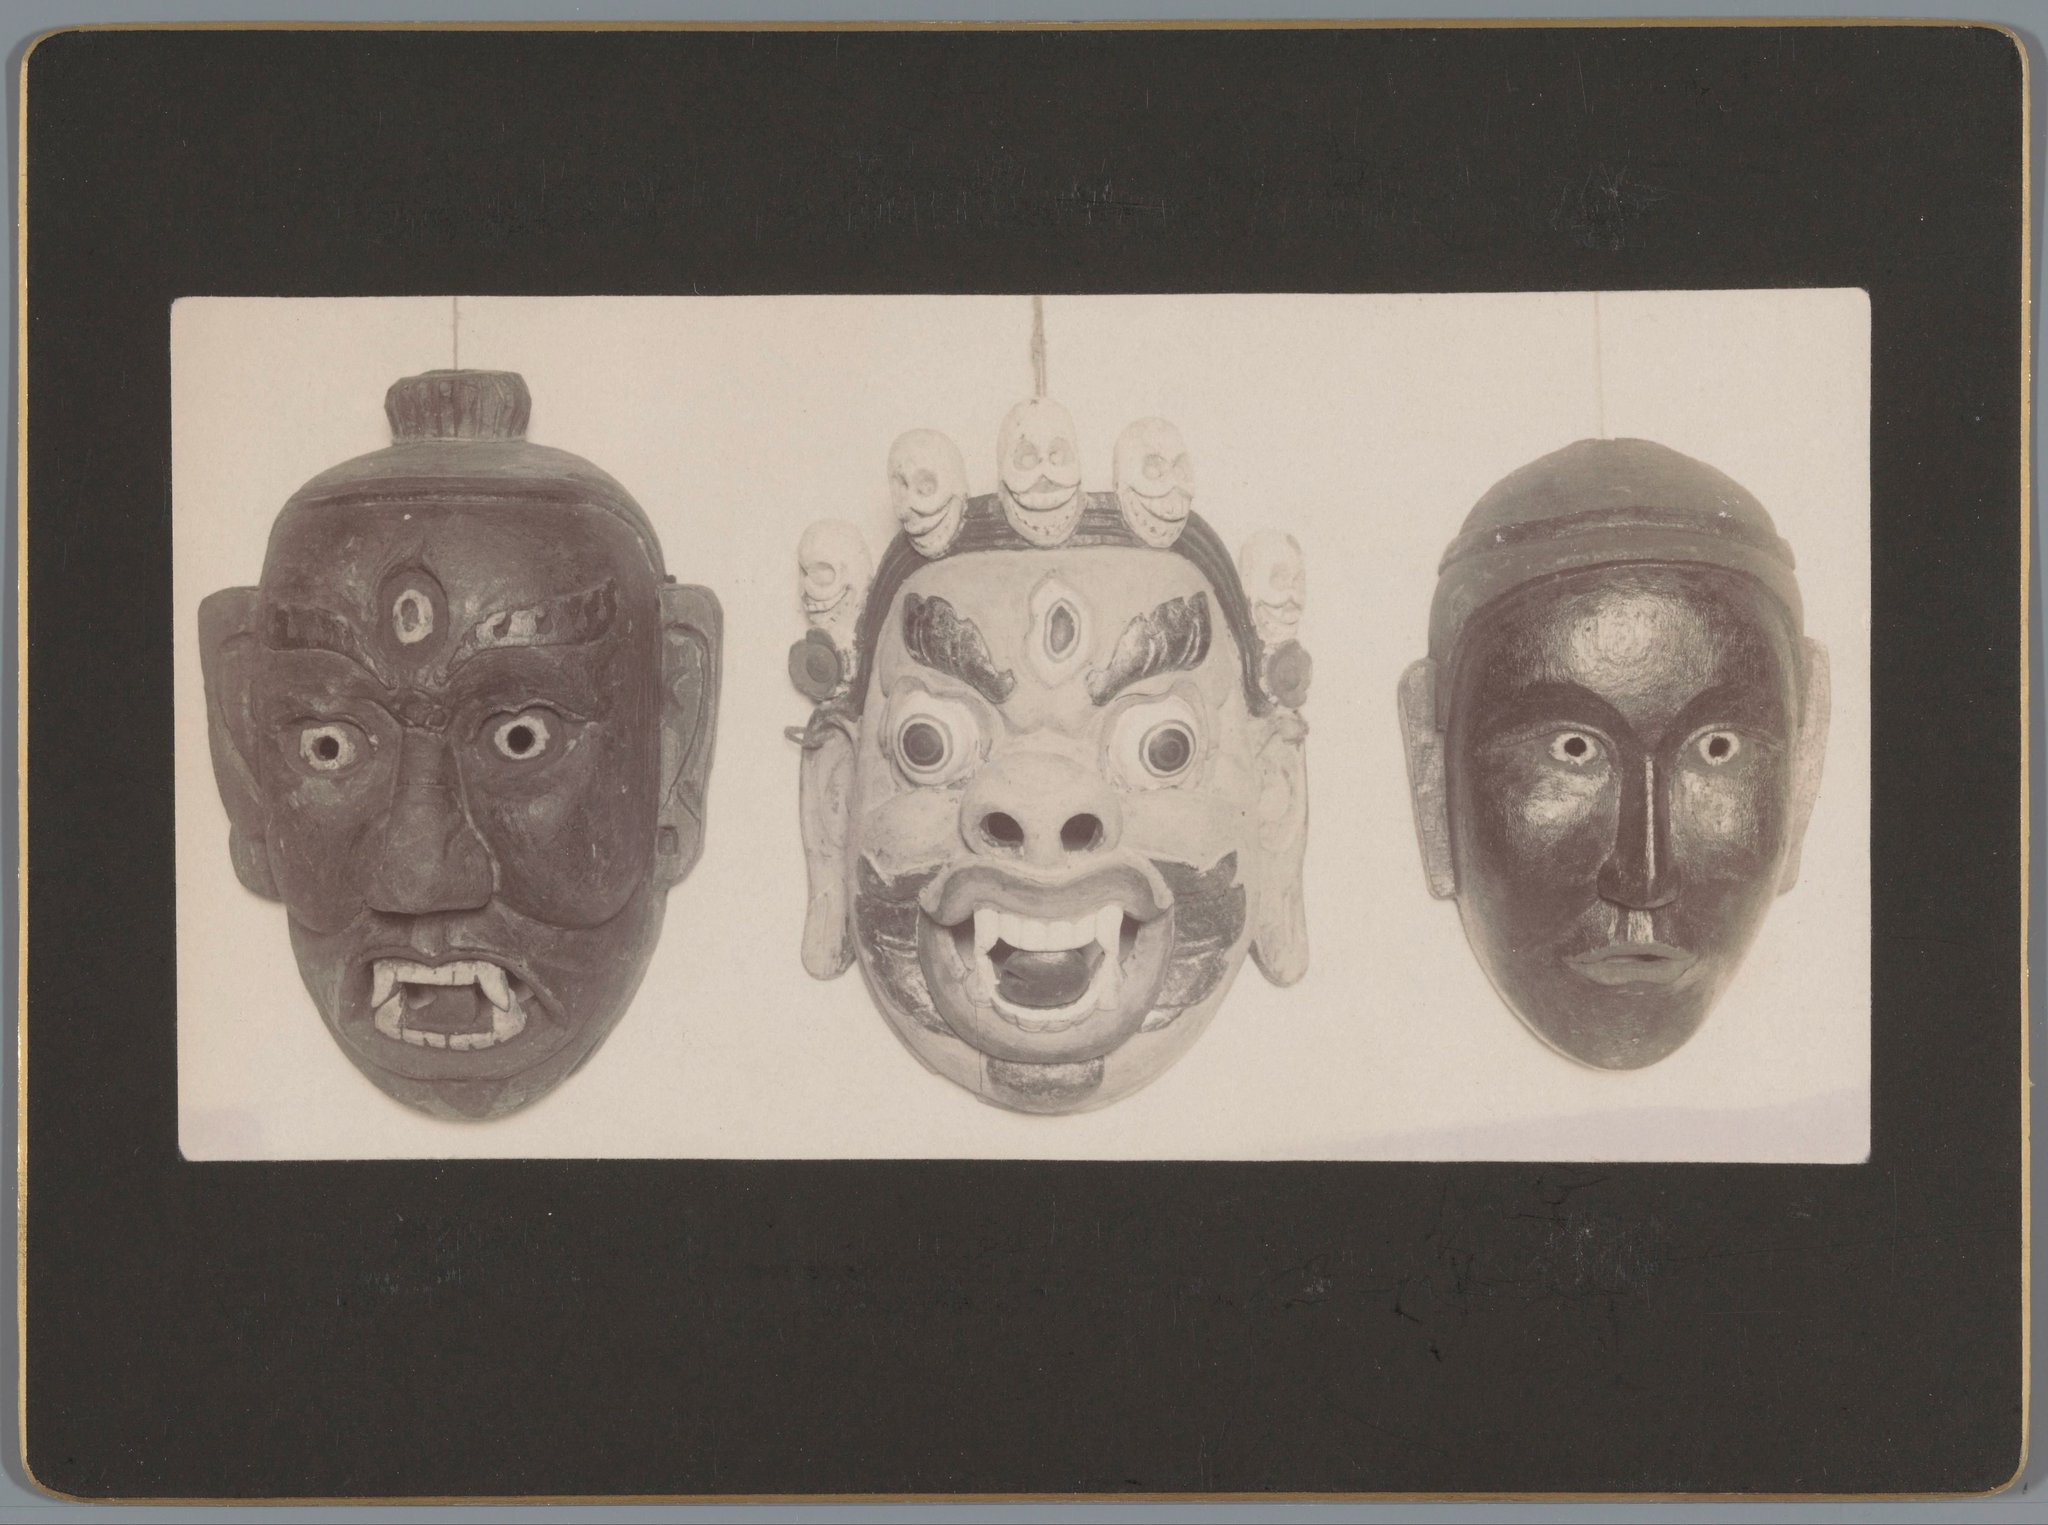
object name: photograph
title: Drie Tibetaanse maskers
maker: Anonymous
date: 1897-1910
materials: cardboard, paper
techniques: albumen print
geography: rijks ethnographisch museum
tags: mask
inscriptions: inscription: ‘hout/ No 46/ hout/ N69/ hout/ N47.’